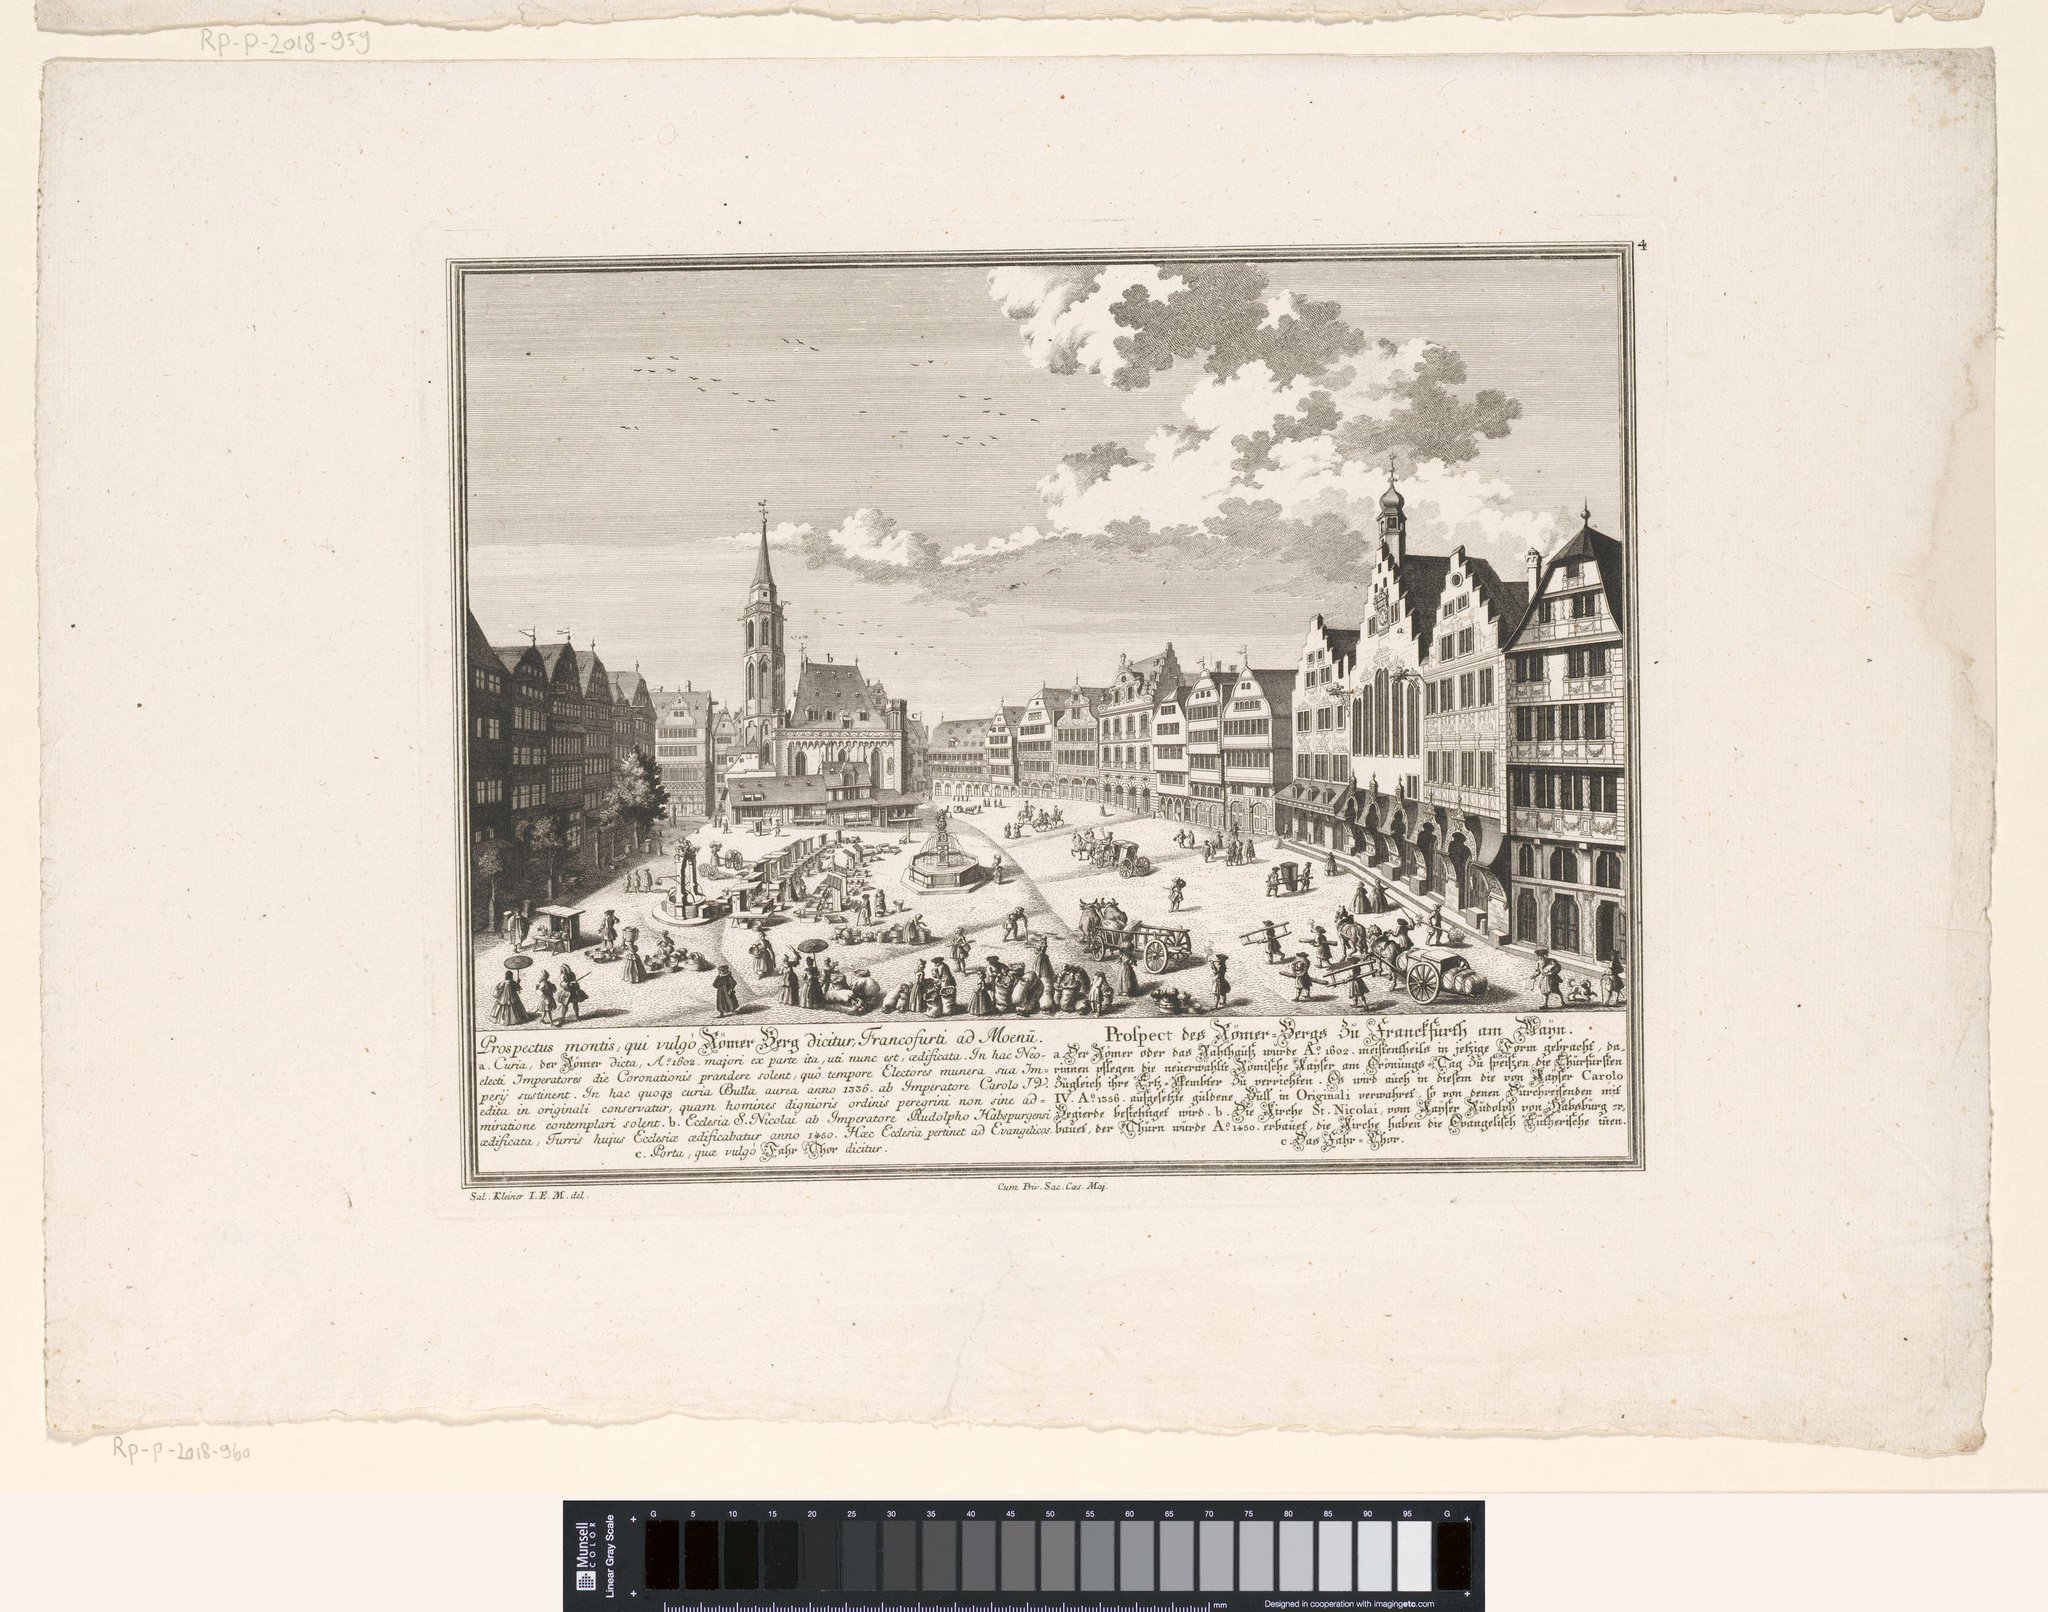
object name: print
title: Prospectus montis, qui vulgó Römer-Berg dicitur, Francofurti ad Moenu (...) / Prospect des Römer-Bergs zu Frankfurth am Maïn (...)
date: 1738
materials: paper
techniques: engraving, etching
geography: augsburg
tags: square, place, circus, etc., city-view in general; 'veduta' - ii - ideal city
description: Prent gebruikt in: Francofurtum ad Moenum Floridum (...). Augsburg: Johann Andreas Pfeffel, 1738.